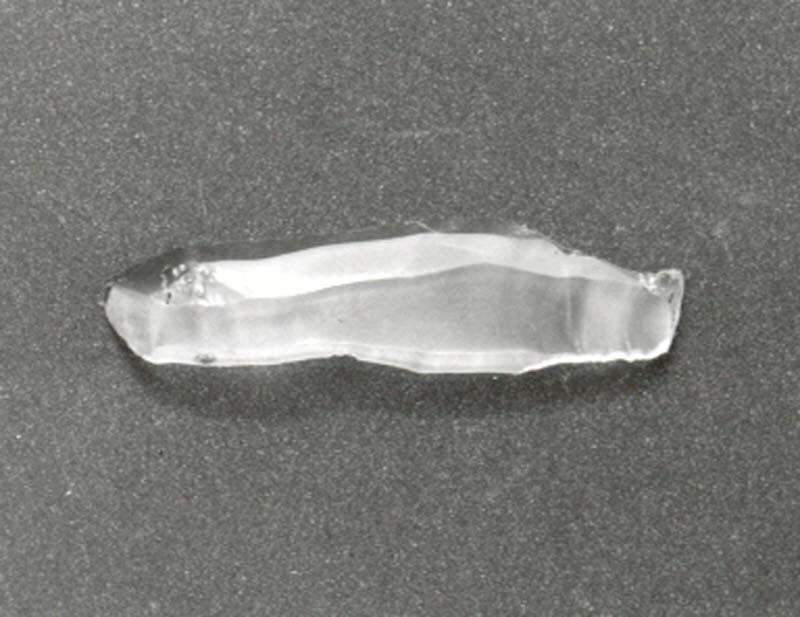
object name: tool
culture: iranian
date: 5000-2001 BCE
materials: obsidian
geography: iran